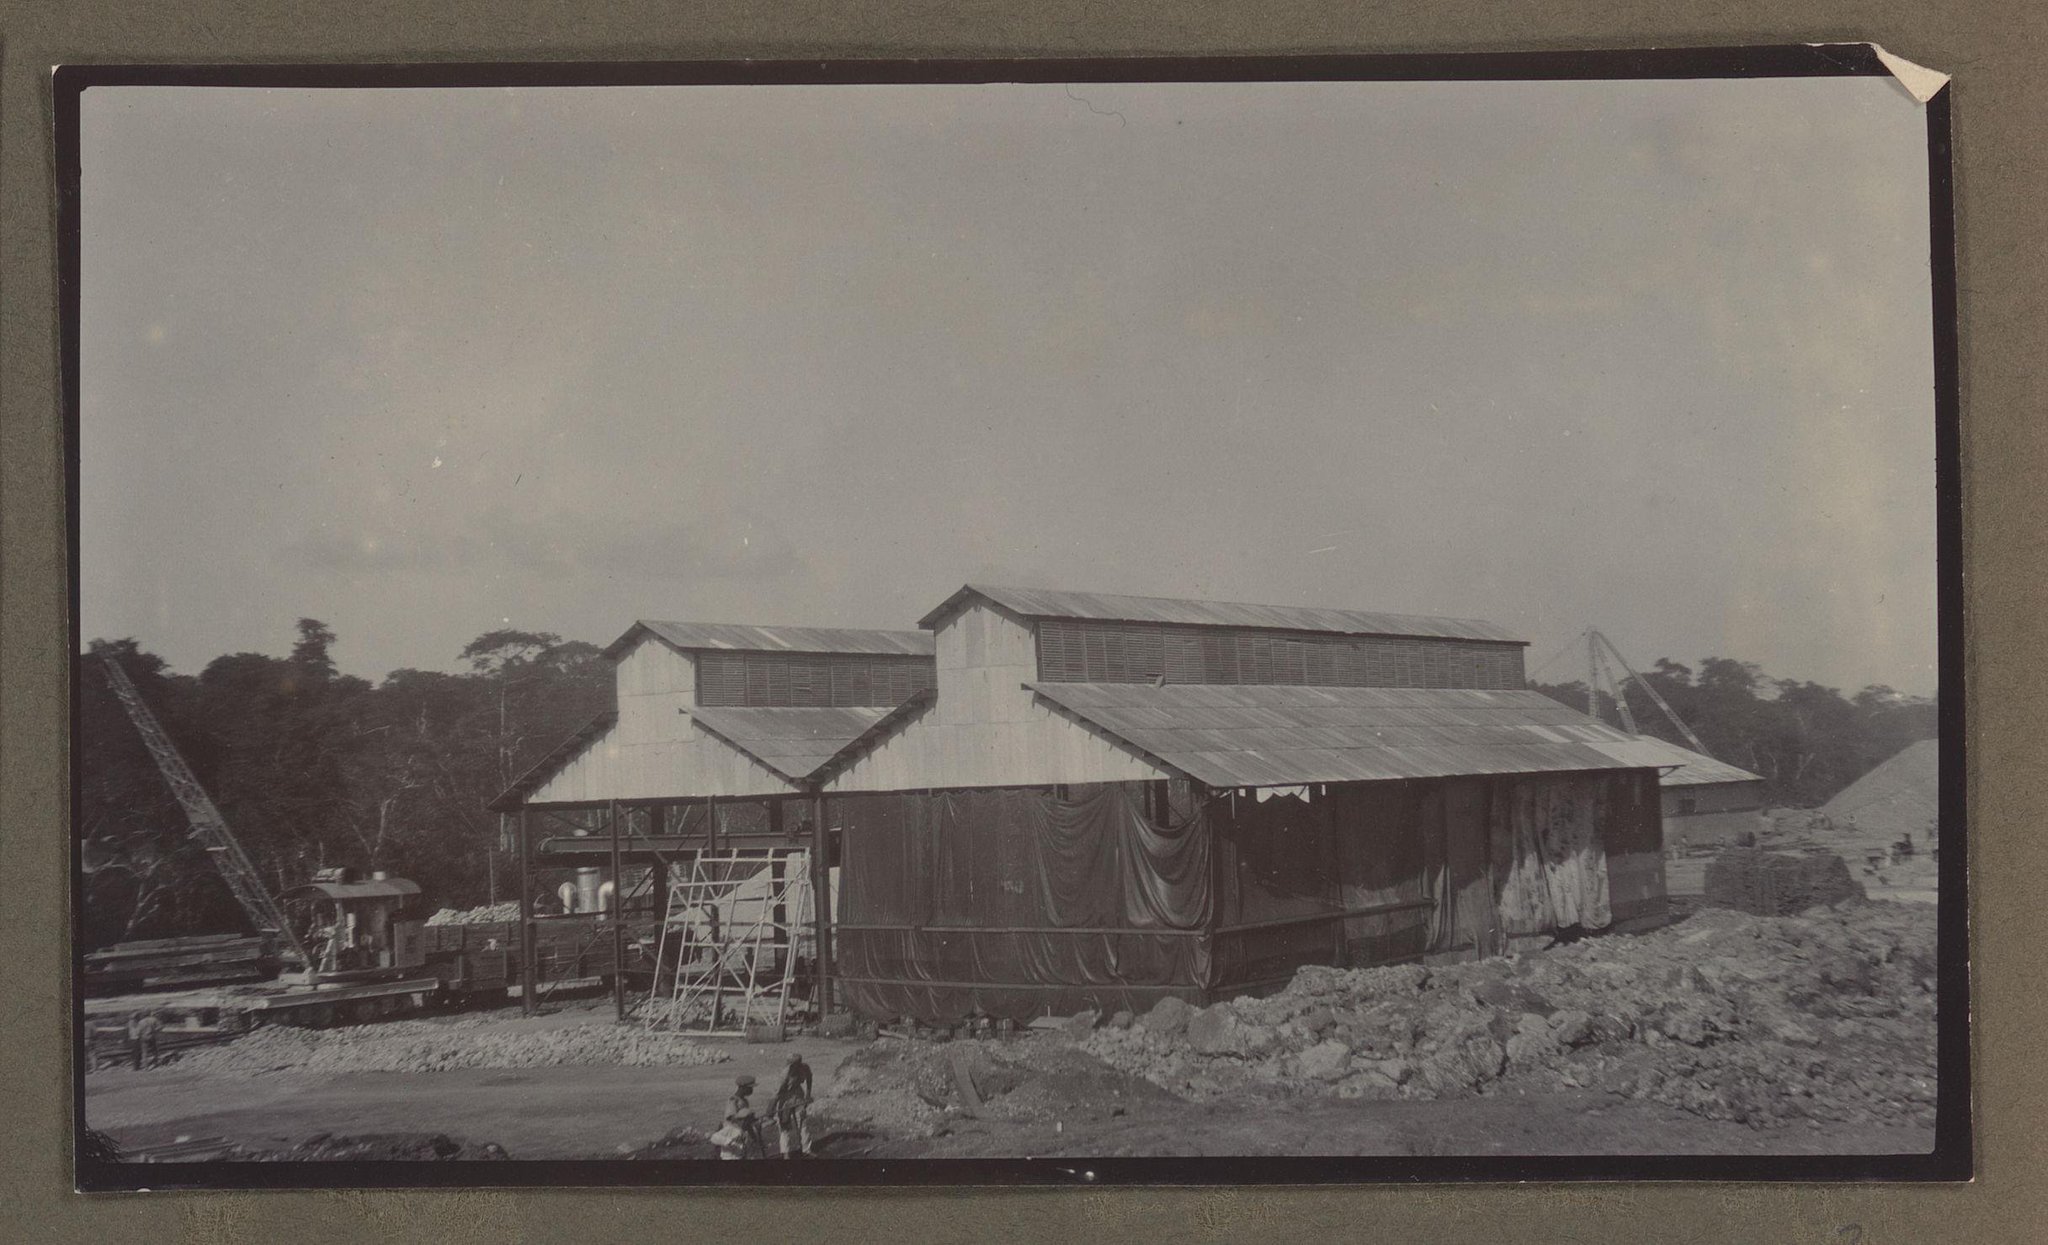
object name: photograph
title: Mijn en fabriek te Moengo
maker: Anonymous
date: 1925-1927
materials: photographic support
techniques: photography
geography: suriname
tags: jetten, familie, moengo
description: Het terrein van de mijn en fabriek te Moengo. Foto op een bladzijde van een los albumblad. Onderdeel van het ensemble met foto's van de familie van ingenieur Jetten in de mijnbouwstad Moengo in Suriname.